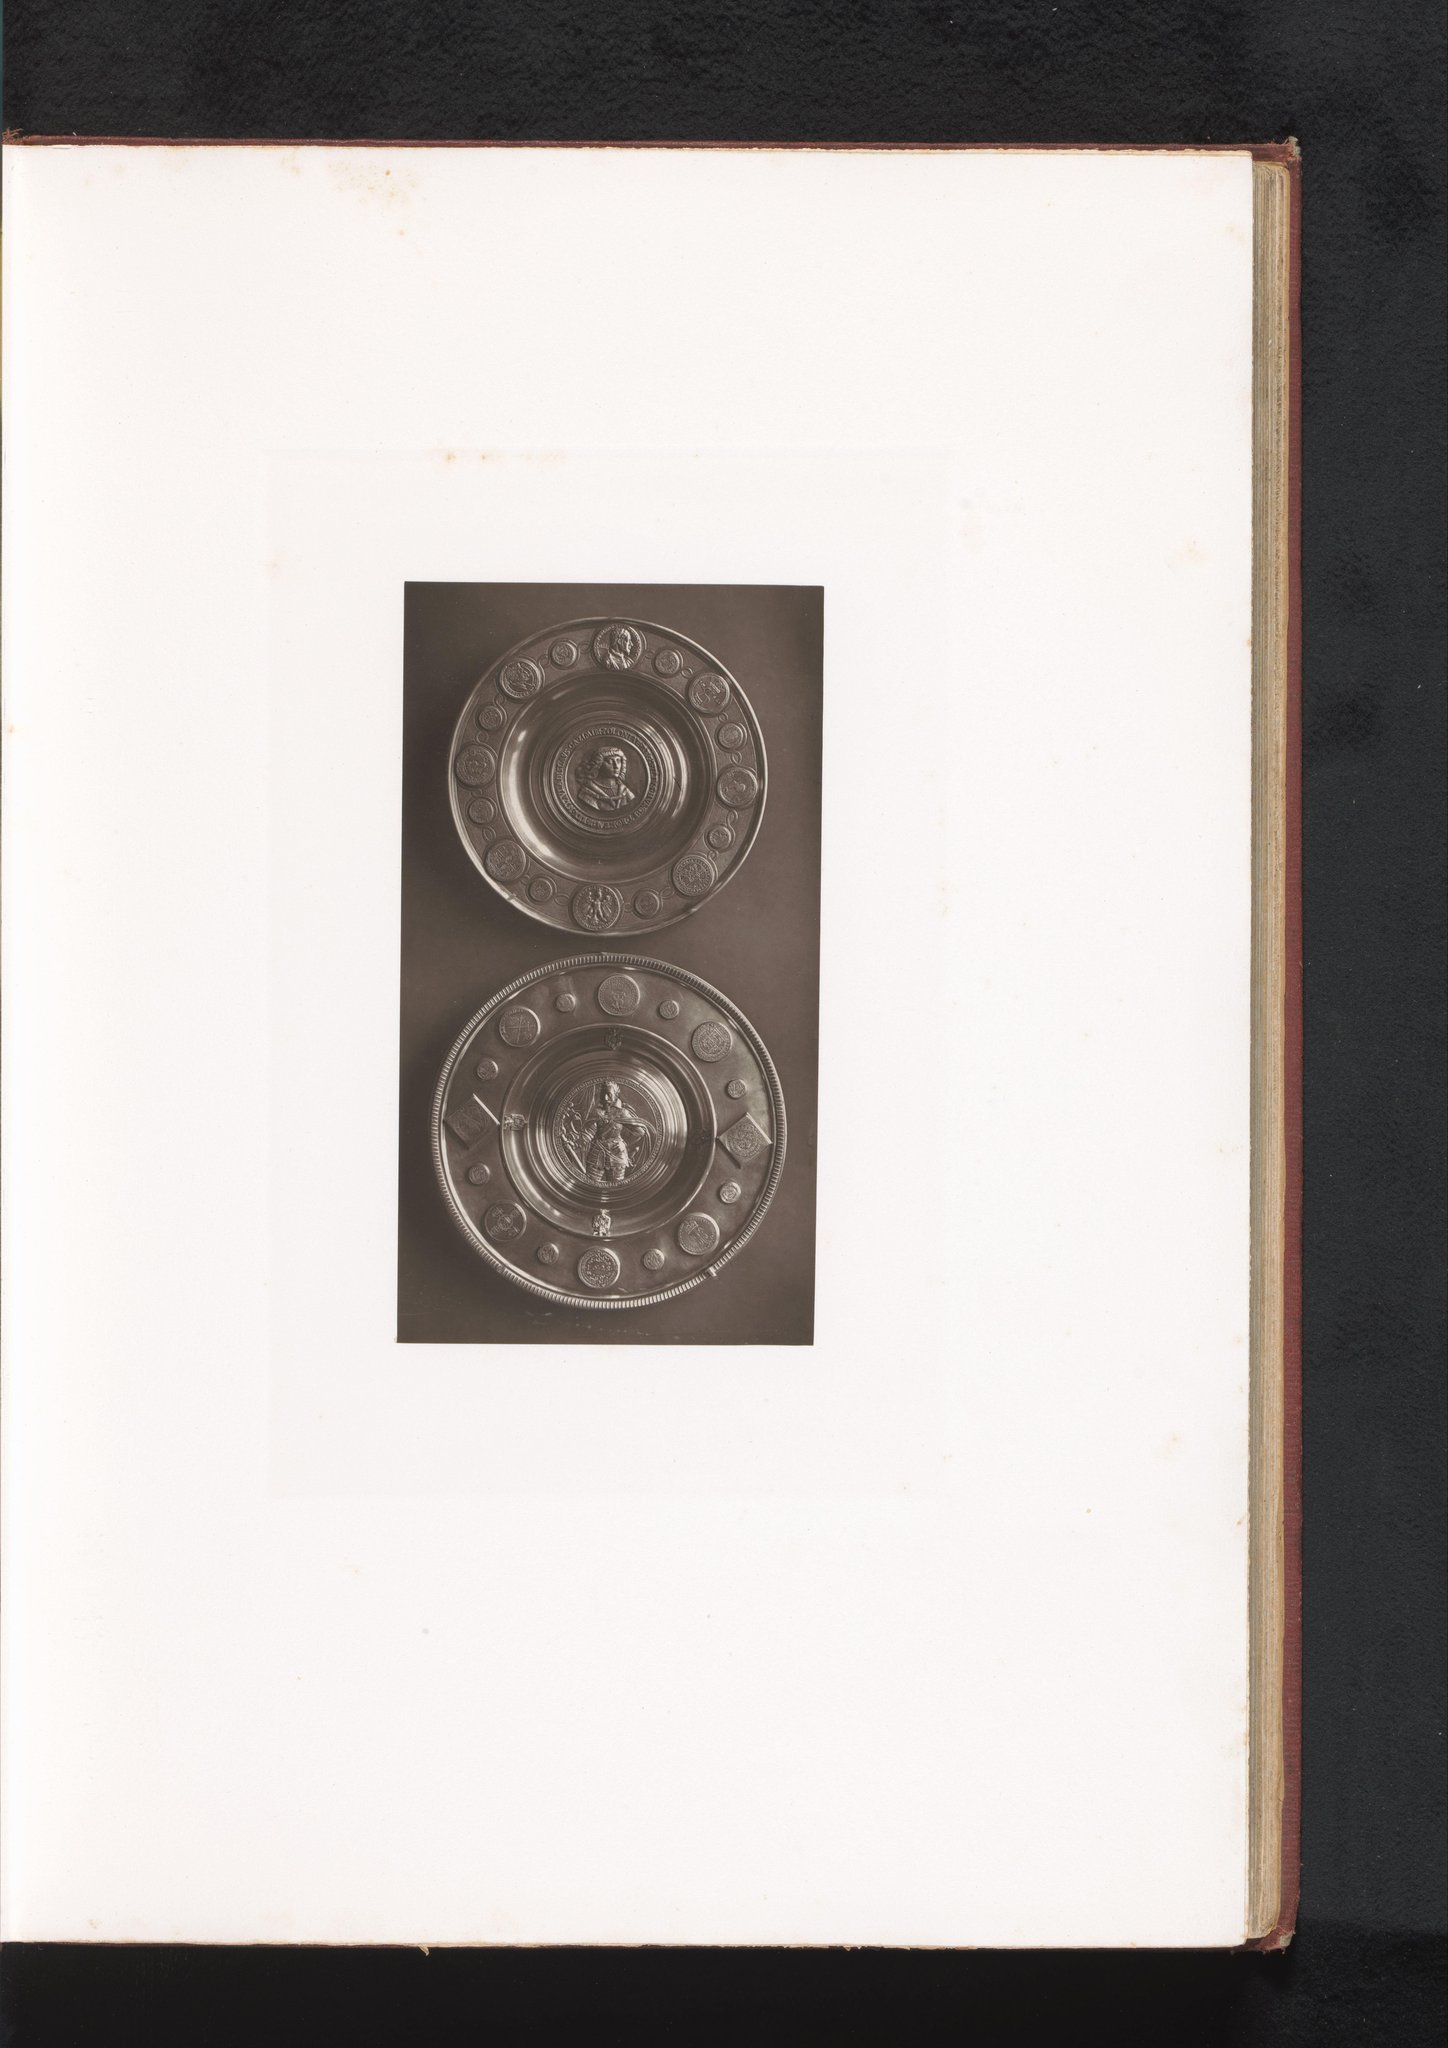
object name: photomechanical print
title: Twee metalen borden, opgesteld tijdens de Exposition Rétrospective van 1873 in Tours, Frankrijk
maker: gabriel blaise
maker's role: printer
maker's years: 1827-1897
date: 1873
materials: paper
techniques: woodburytype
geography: tours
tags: breakfast, temporary exhibition, 'salon'